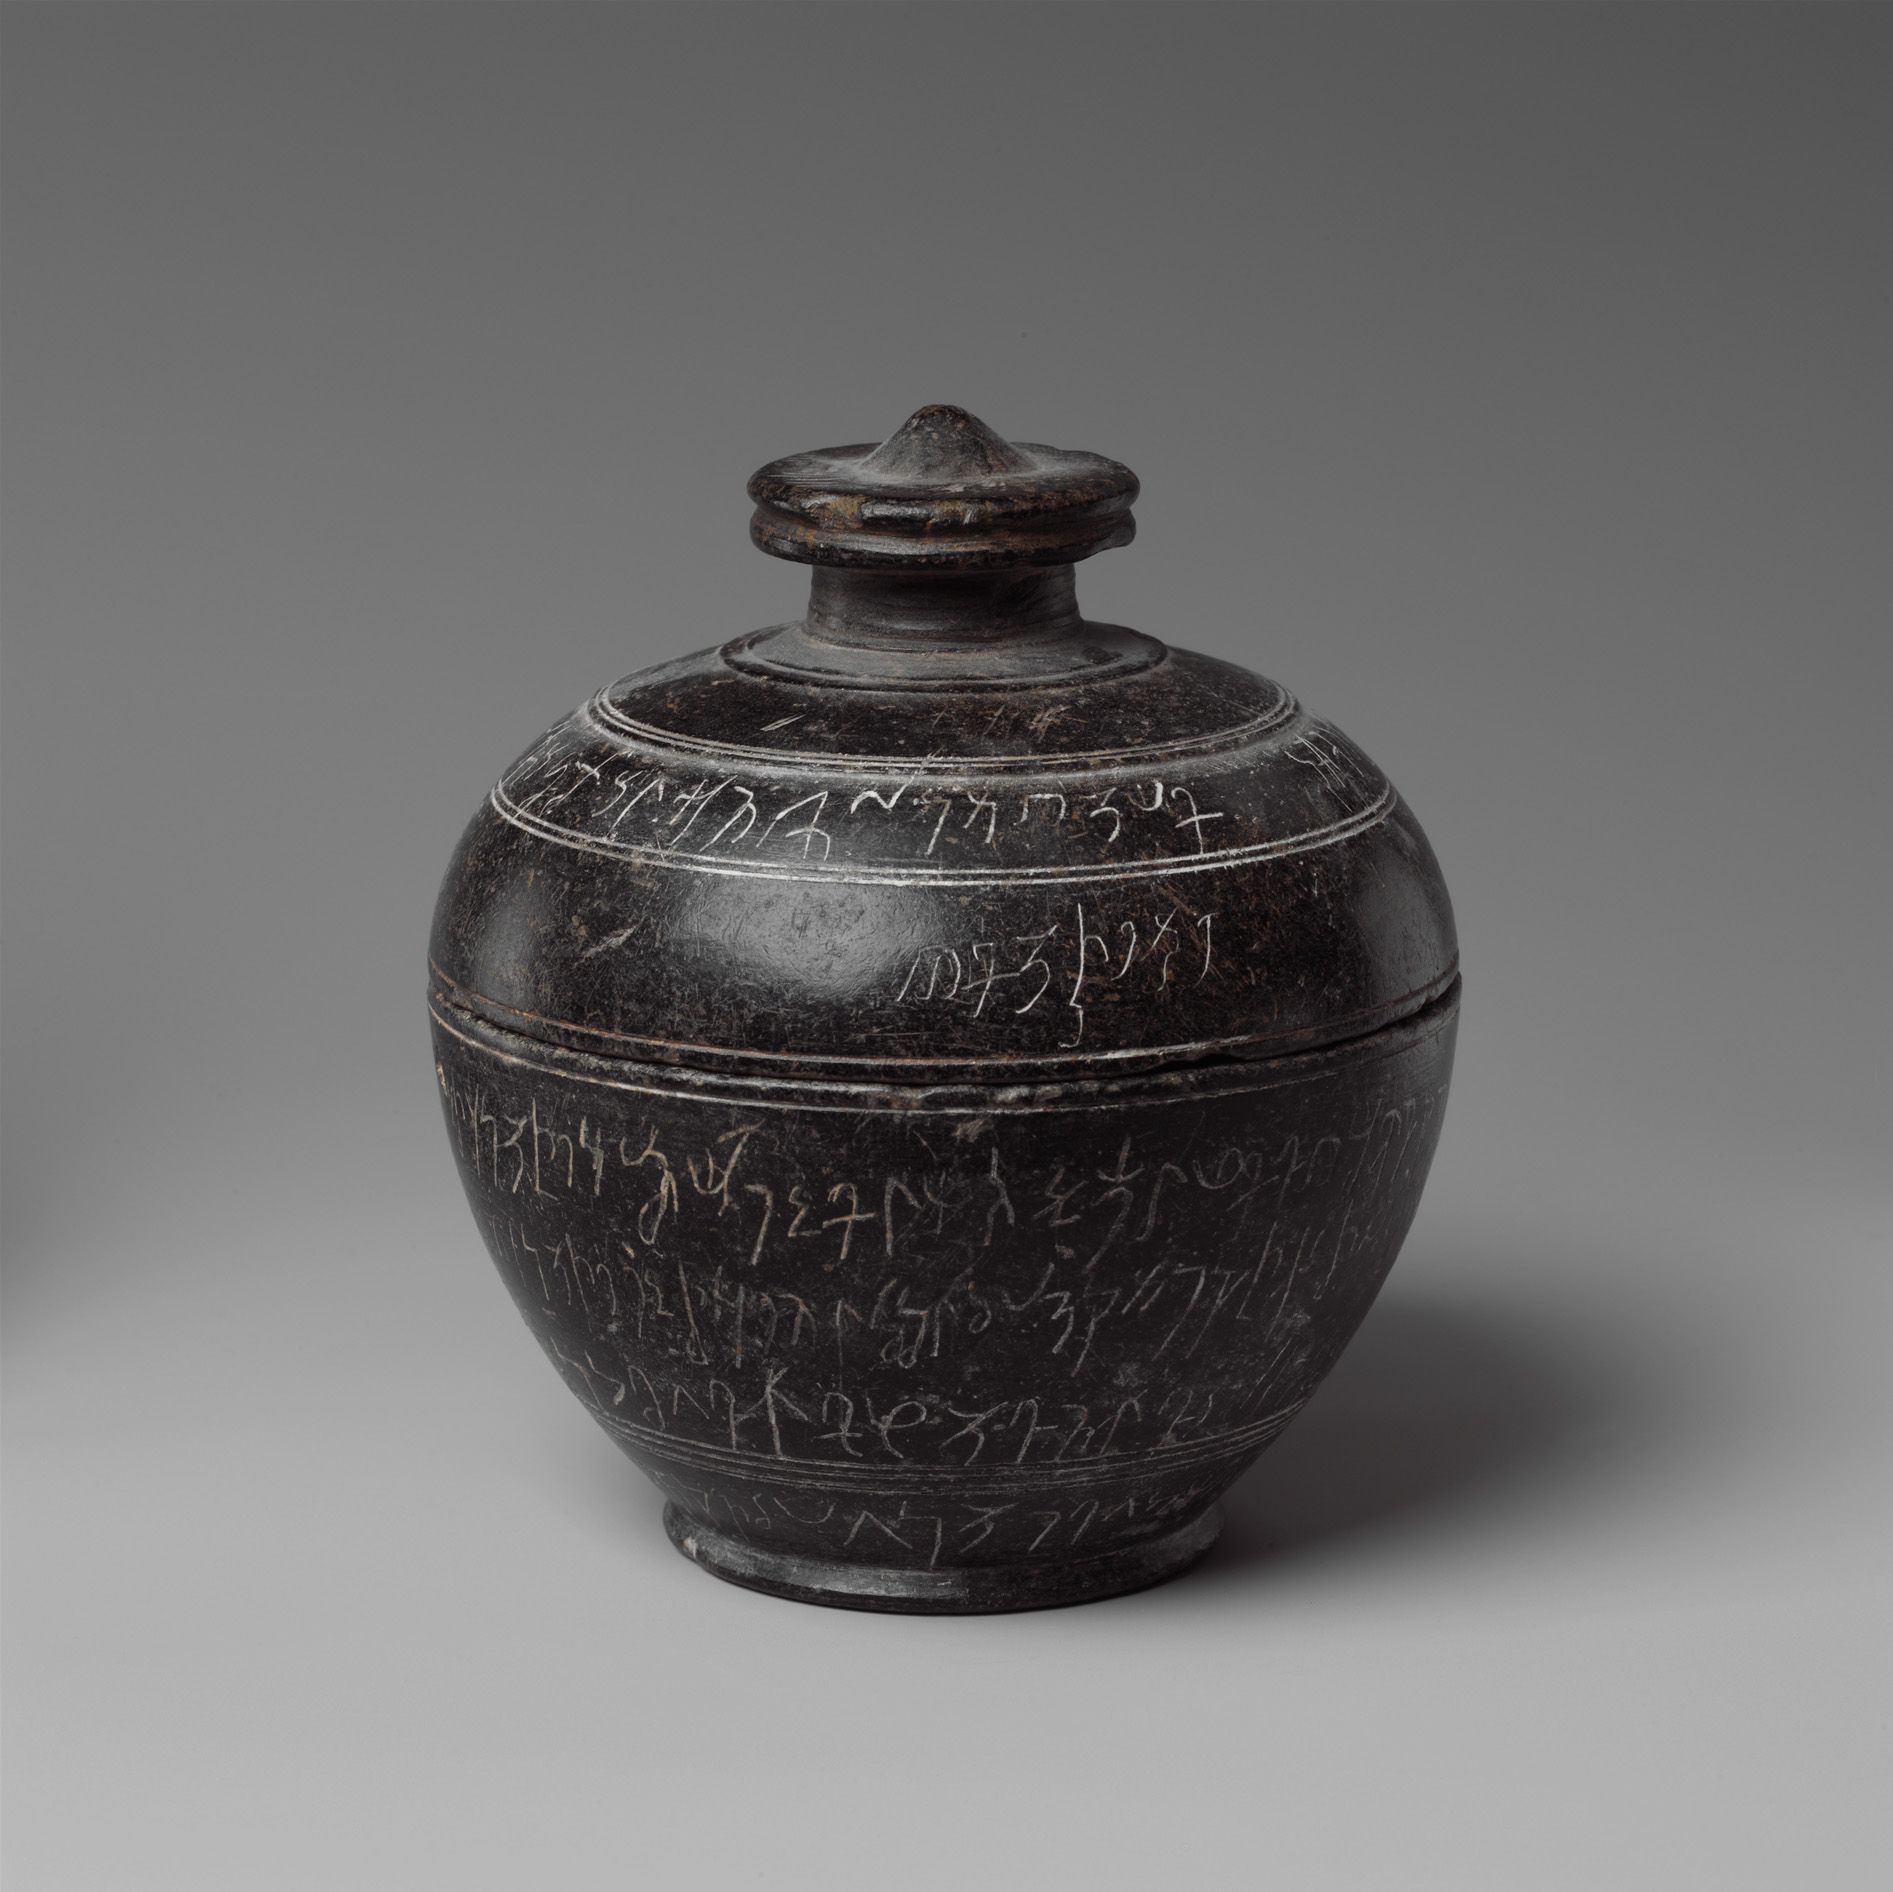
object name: reliquary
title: Inscribed Reliquary, Donated by King Indravarman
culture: pakistani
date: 5-6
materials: stone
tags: gandhara